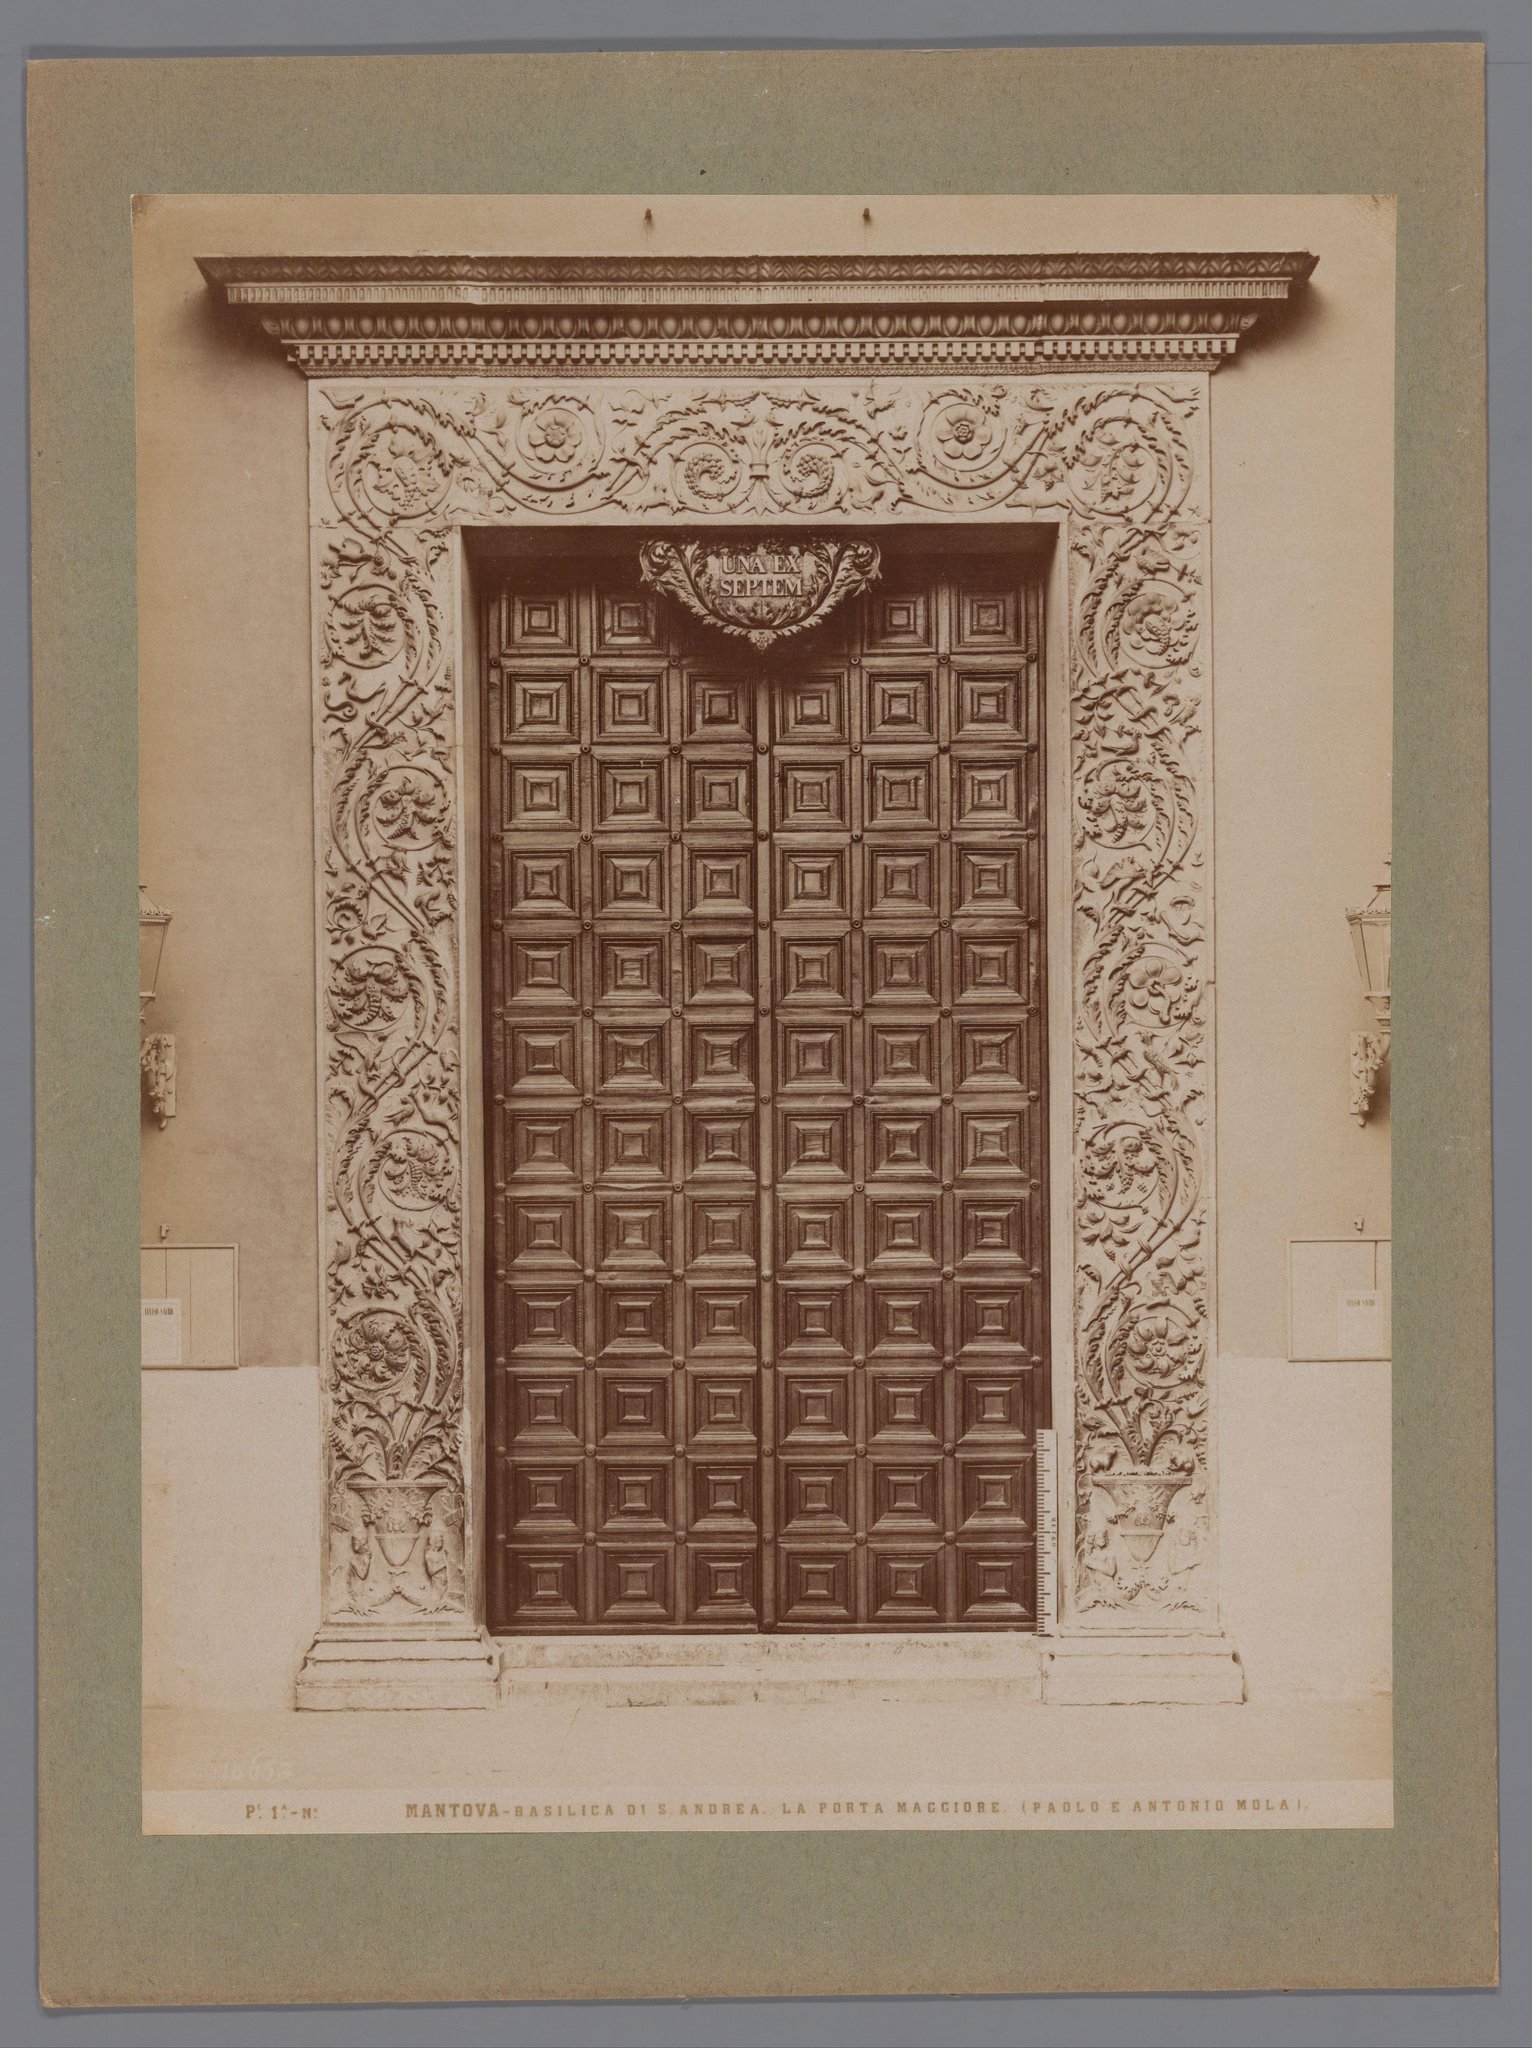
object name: photograph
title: Hoofdingang van de San Andrea te Mantua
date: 1851-1900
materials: cardboard, paper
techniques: albumen print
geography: mantua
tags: parts of church exterior and annexes: portal, door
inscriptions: number: ‘Pl. 1A - No.’